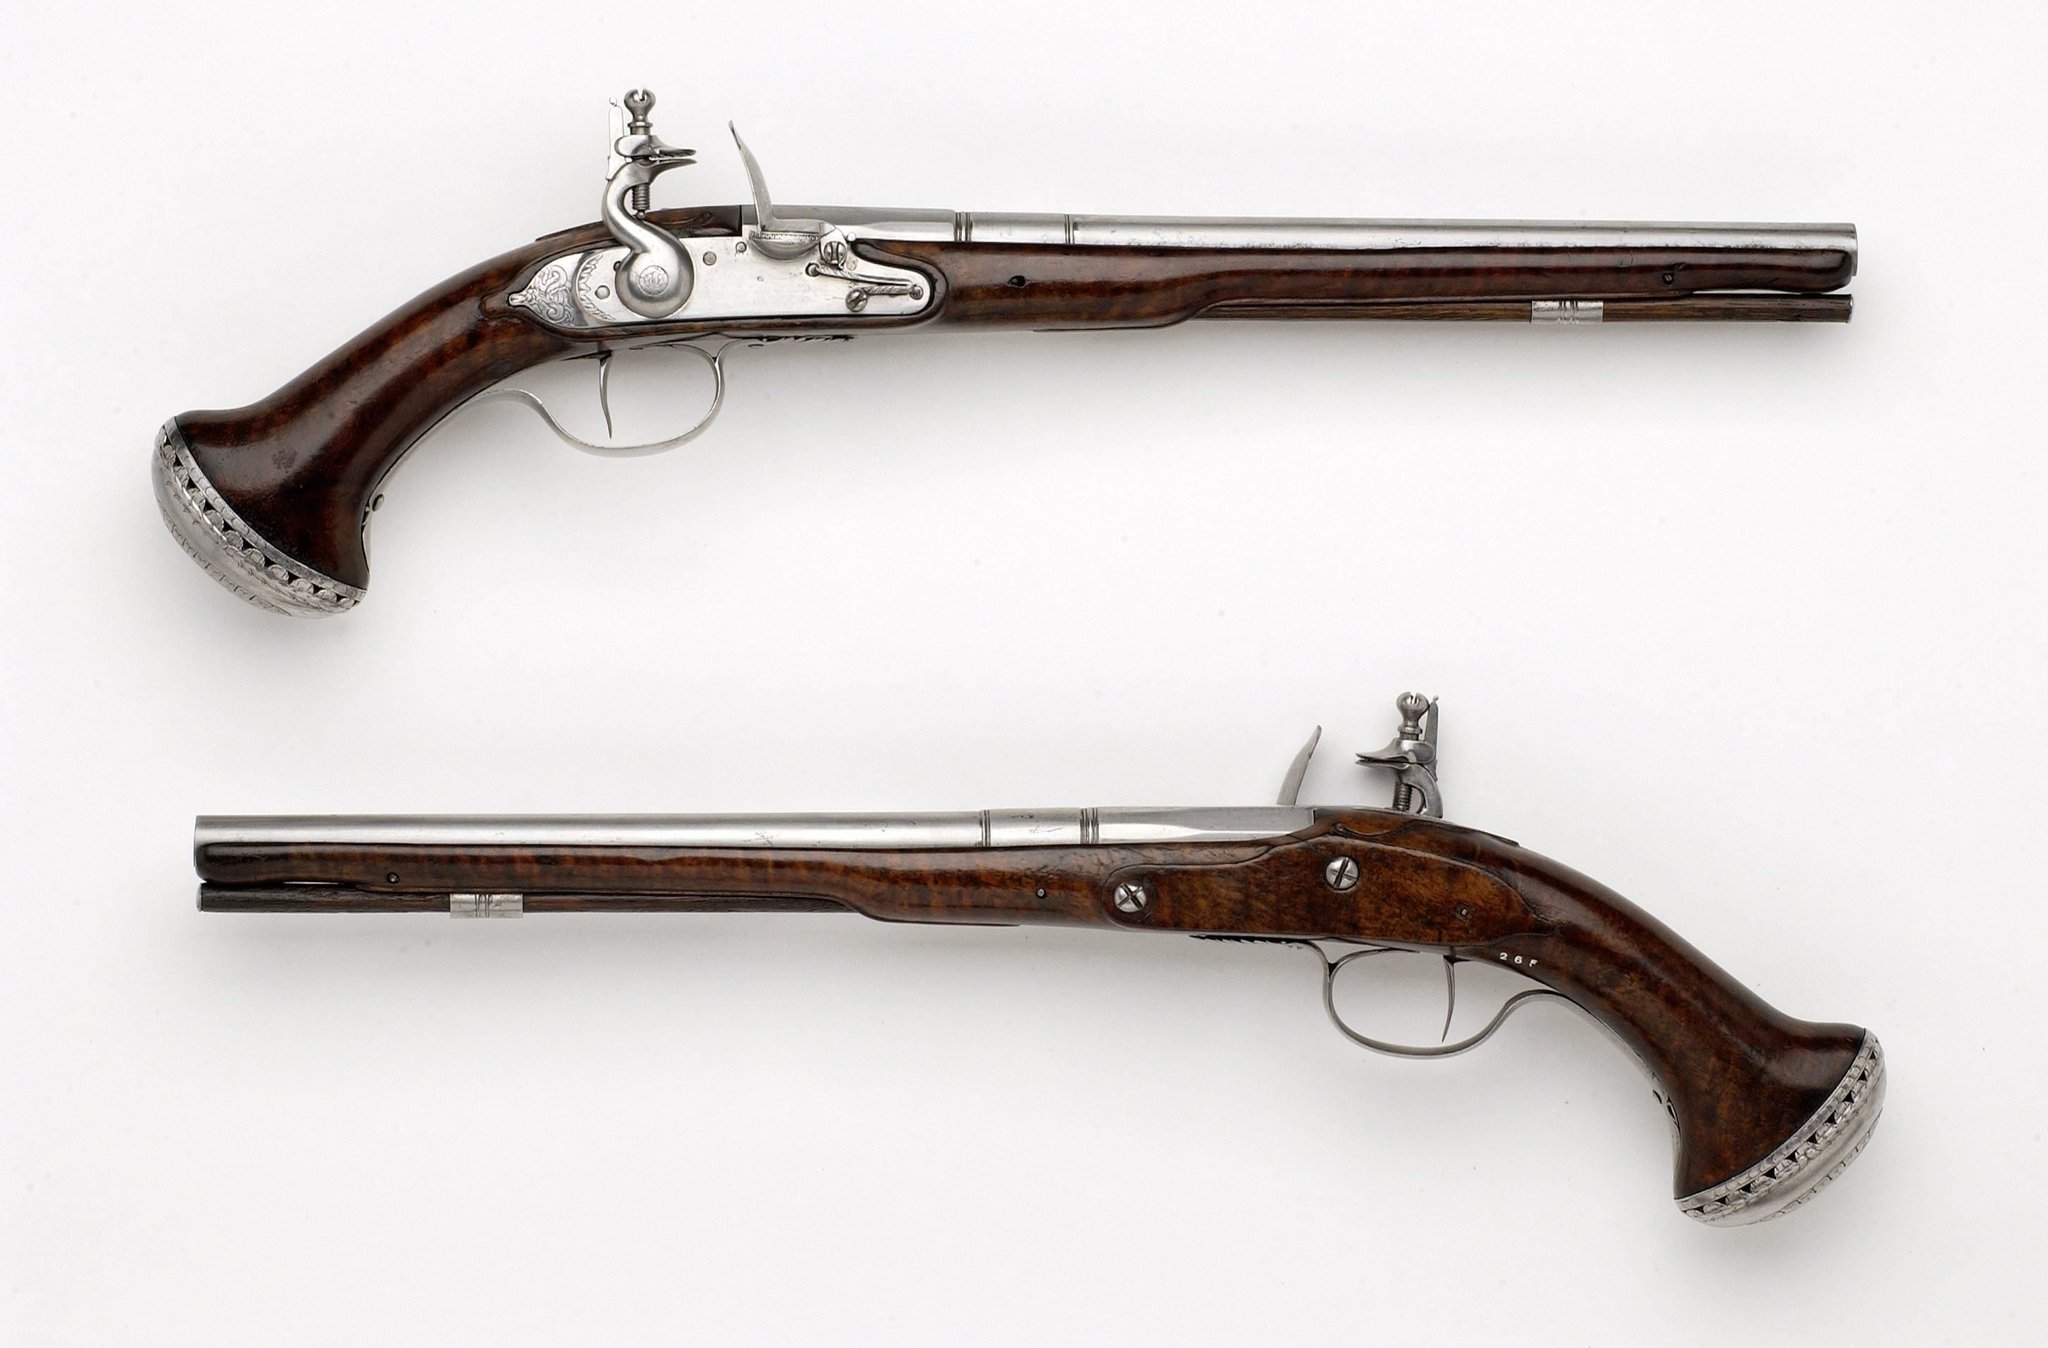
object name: flintlock pistol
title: Vuursteenpistool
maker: Anonymous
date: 1655-1660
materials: iron, wood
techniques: printing, embroidery, engraving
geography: netherlands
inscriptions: mark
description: Niet gemerkt, doch zeer Hollands van vorm en uitvoering. Op de slotplaat staat een draak gegraveerd met lofwerk. De loop is voorzien van twee ringen en onderop gestempeld met een niet te identificeren merk. De kolf is eenvoudig gesneden. Het ijzeren beslag bestaat onder meer uit een laadstokkoker en een lusvormige, aan de voorkant gevorkte trekkerbeugel en een bootvormige kolfknop met een ajour bewerkte rand en vogels en lofwerk erop gegraveerd; de laadstok is voorzien van een ijzeren kap.